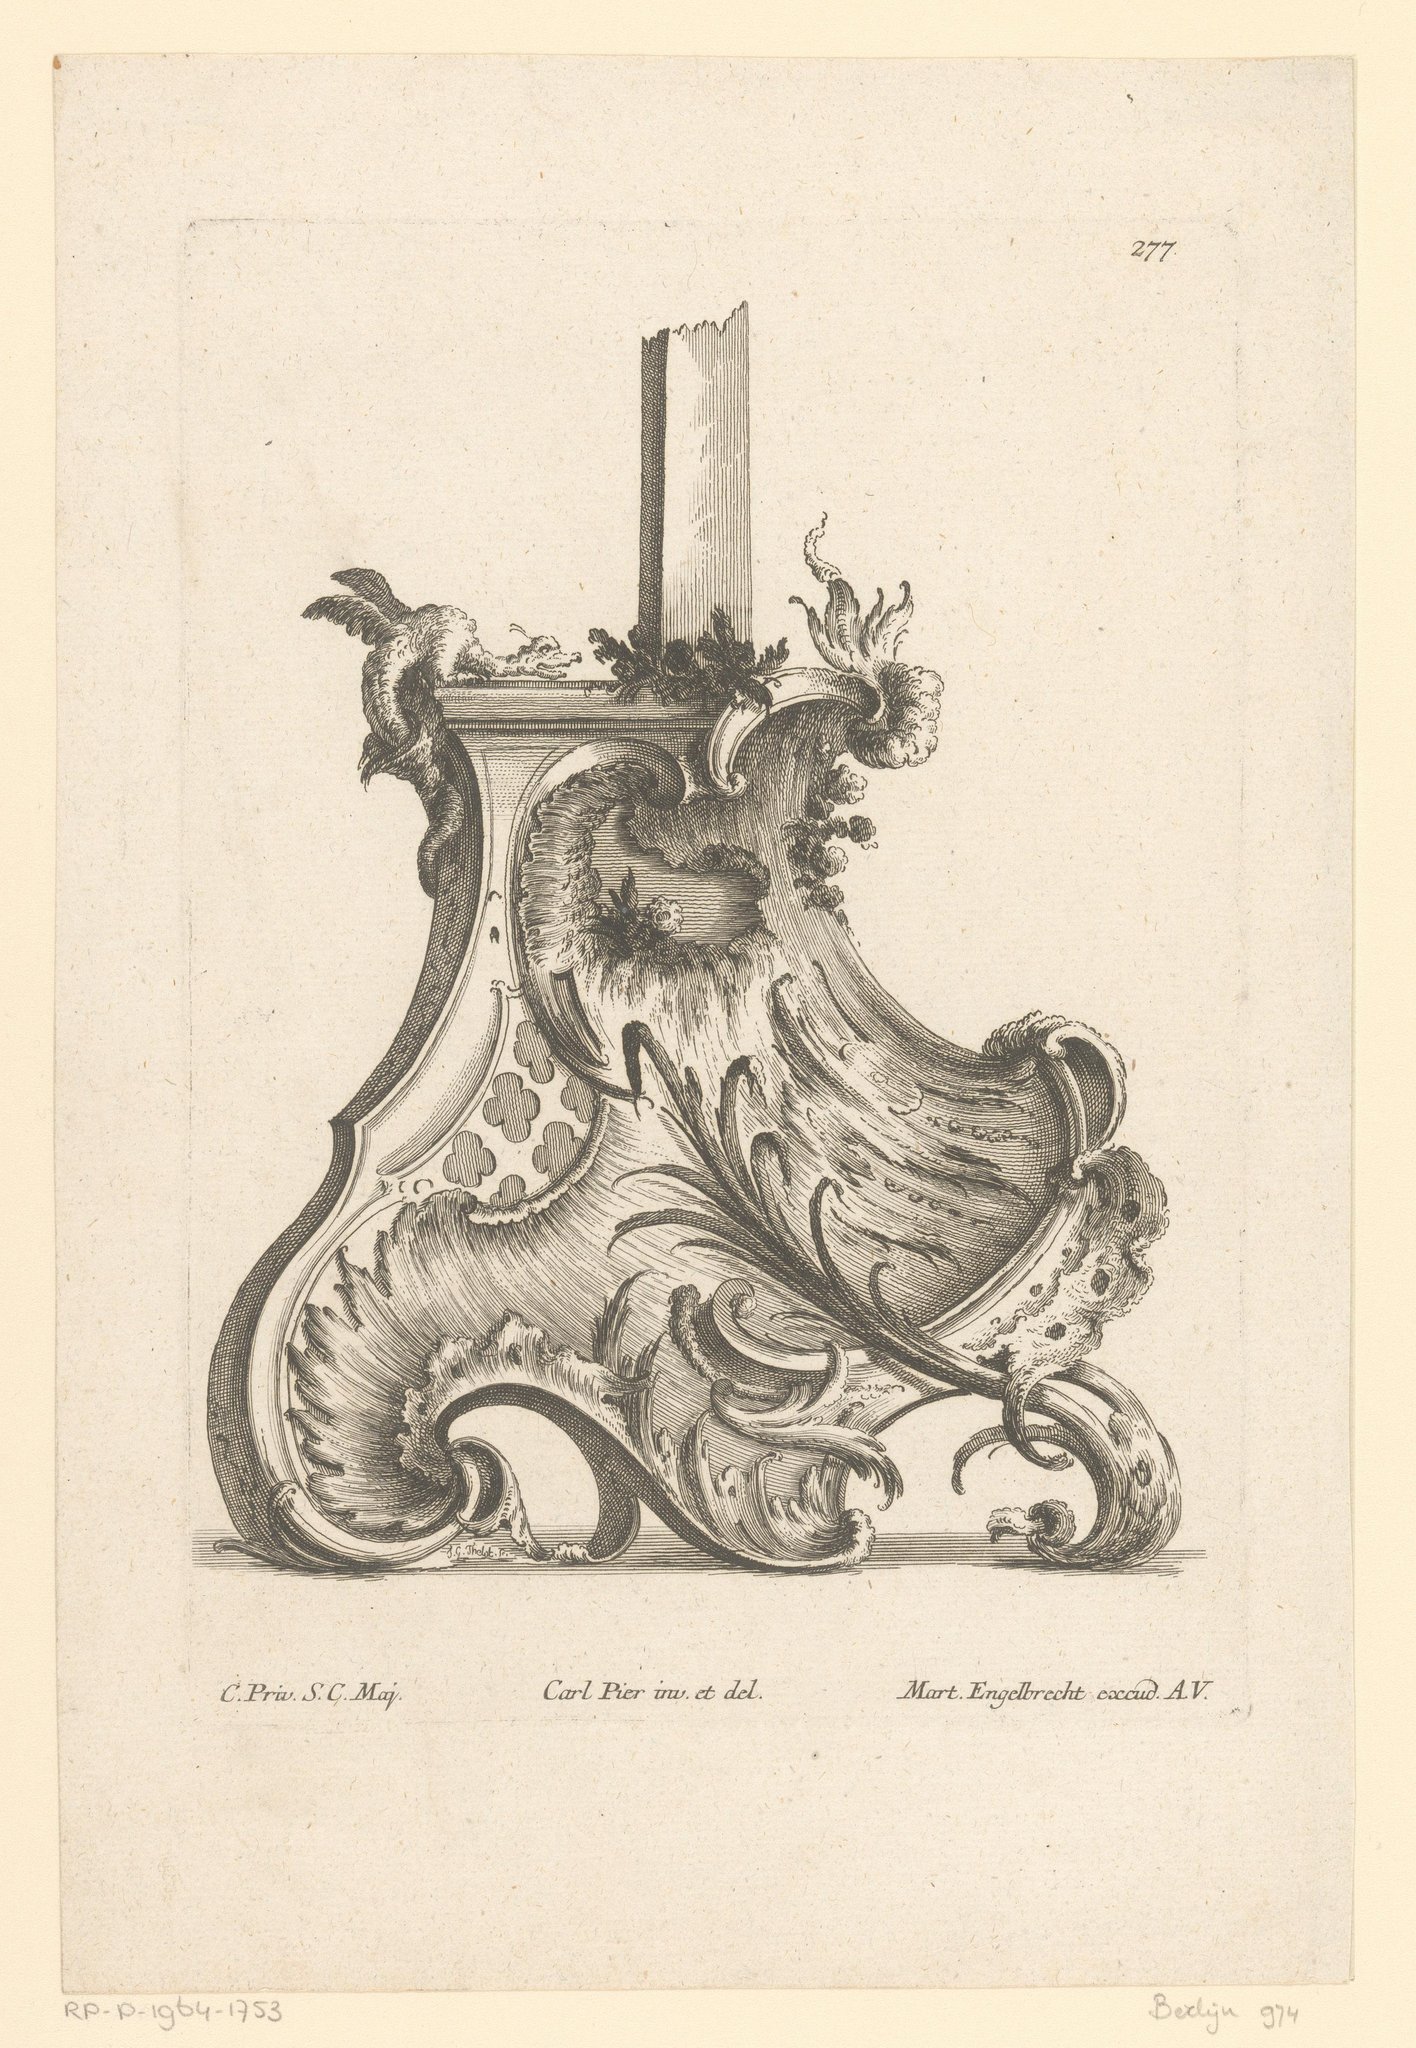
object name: ornament print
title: Neü inventierte Crucifix-Stöcke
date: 1718-1756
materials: paper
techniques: etching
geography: augsburg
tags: altarcross, crucifix, dragon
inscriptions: collector's mark: Lugt 2760, collector's mark: Lugt 2228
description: Ontwerp voor een rocaille kruisbeeldvoet met draakachtige figuur. Prentnummer 277.